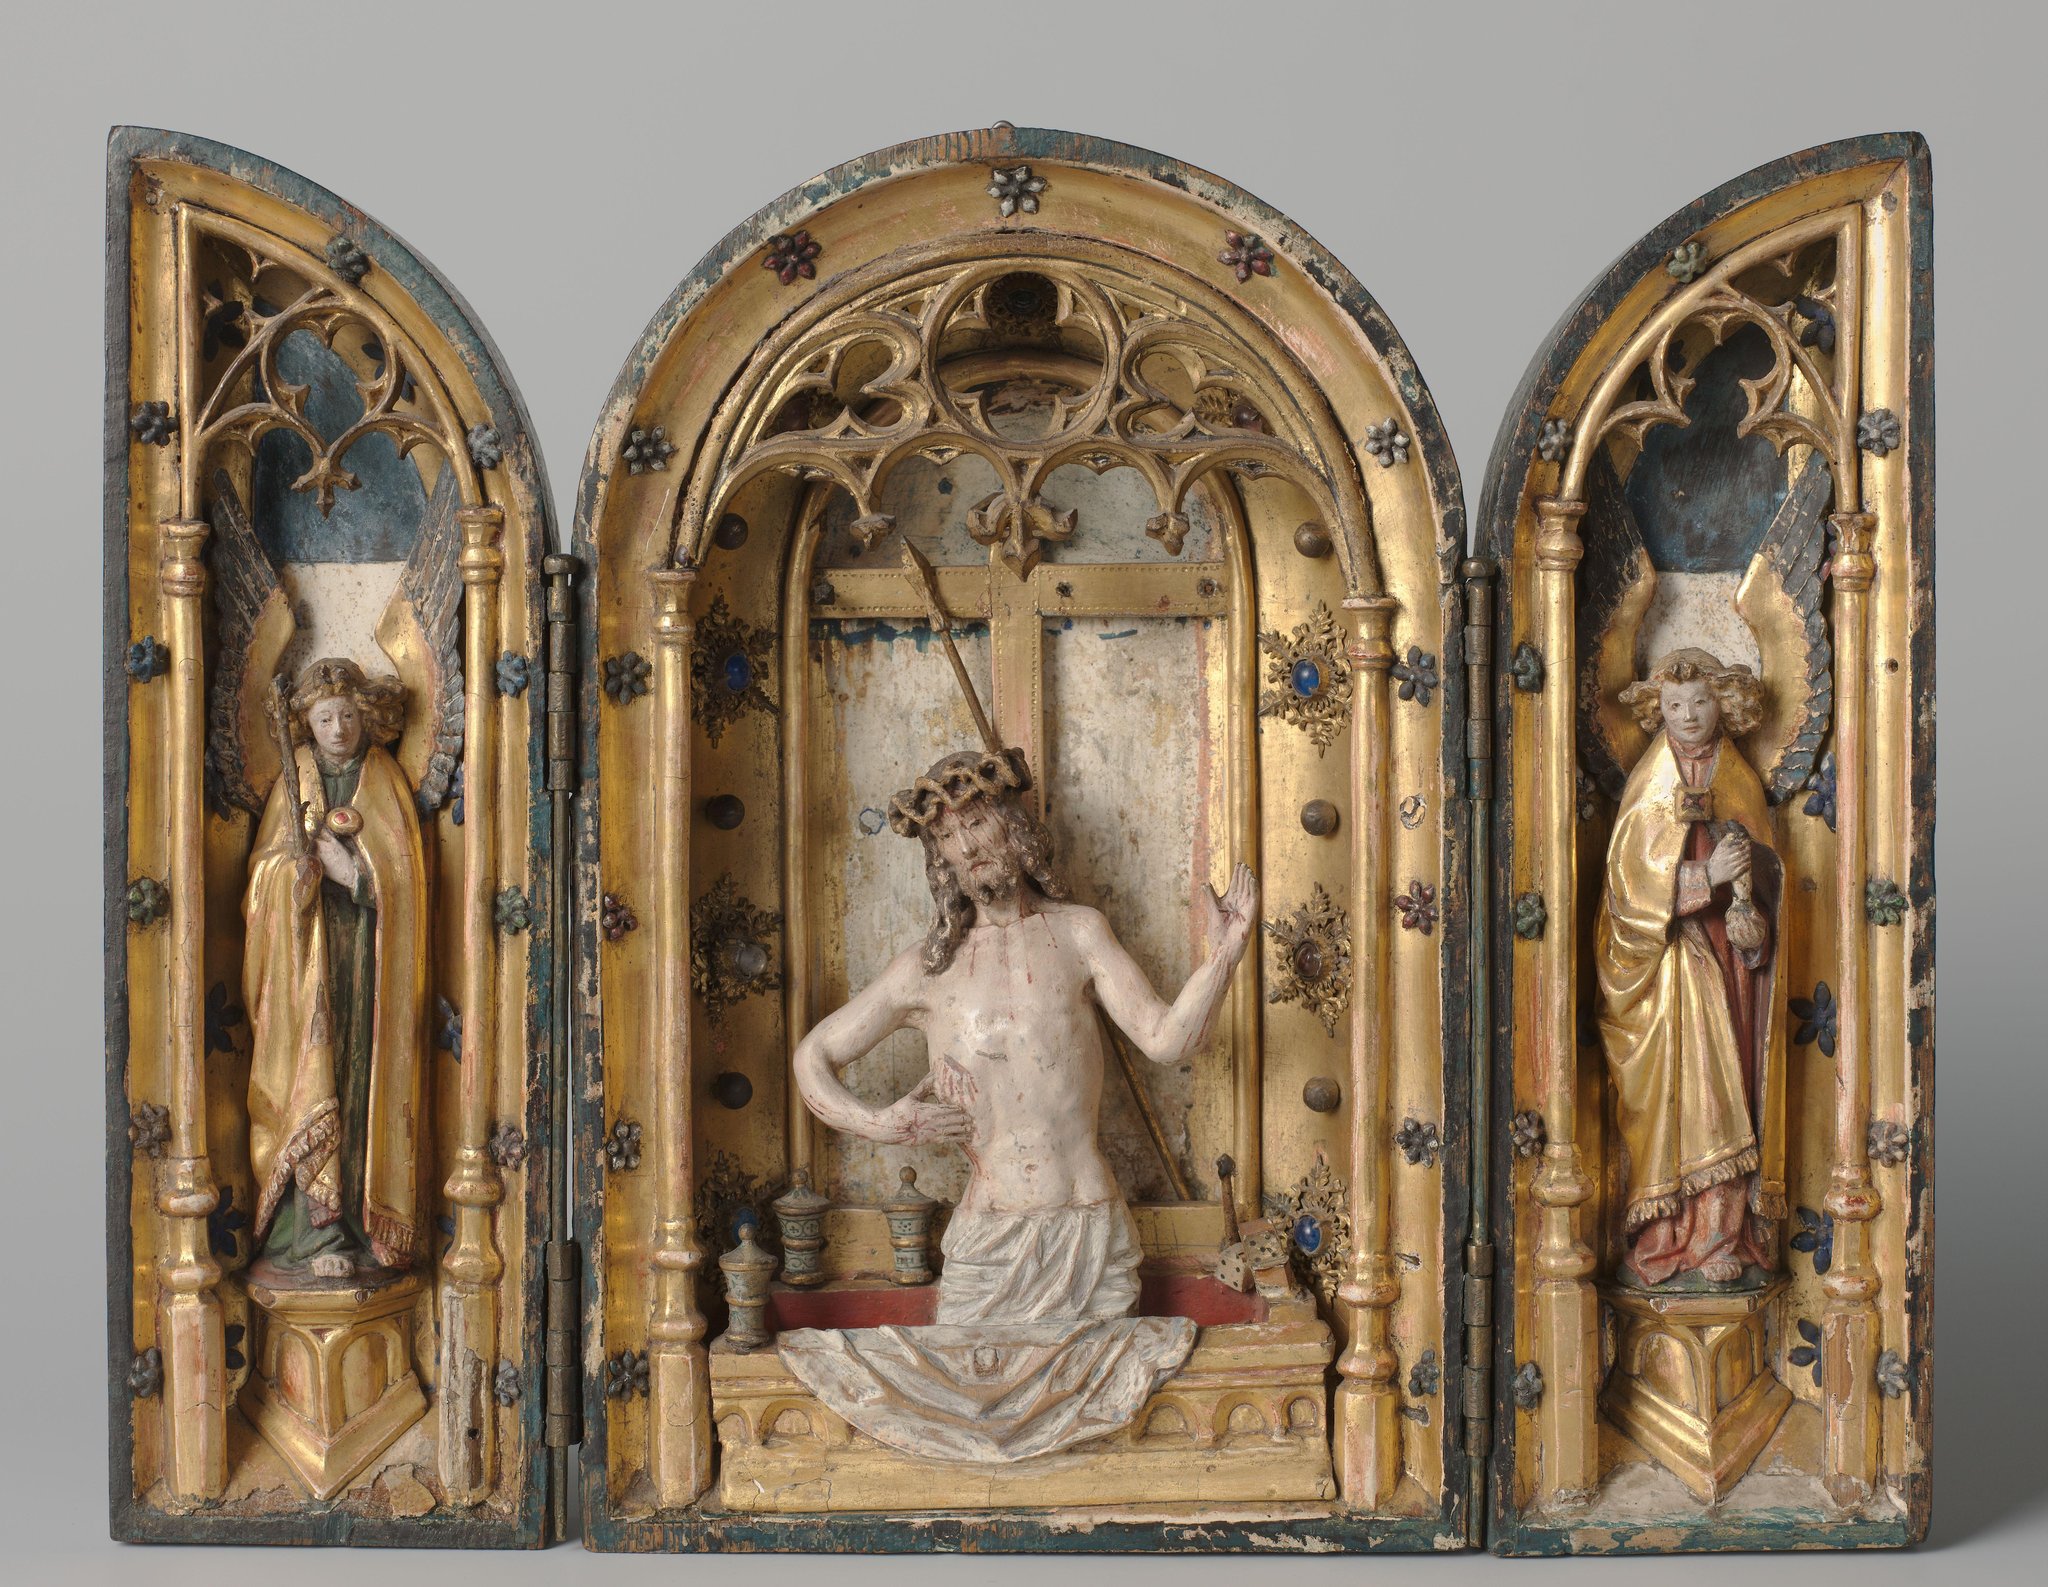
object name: portable altar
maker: Anonymous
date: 1500-1525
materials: copper, glass, lead, wood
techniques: gilding, polychromy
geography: mechelen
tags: man of sorrows, 'imago pietatis', 'erbärmdebild', 'schmerzensmann'; the upright christ showing his wounds, usually bearing the crown of thorns, and accompanied by the instruments of the passion, standing or sitting in his tomb (+ angel(s))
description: This exquisite portable altar was intended for private devotion. The owner could use it for personal meditation either at home or when travelling. Open, the altar presented a poignant image of ‘Christ as the Man of Sorrows’ standing in his tomb and pointing explicitly at the wounds caused by his crucifixion. This helped the believer to identify with Christ’s suffering.